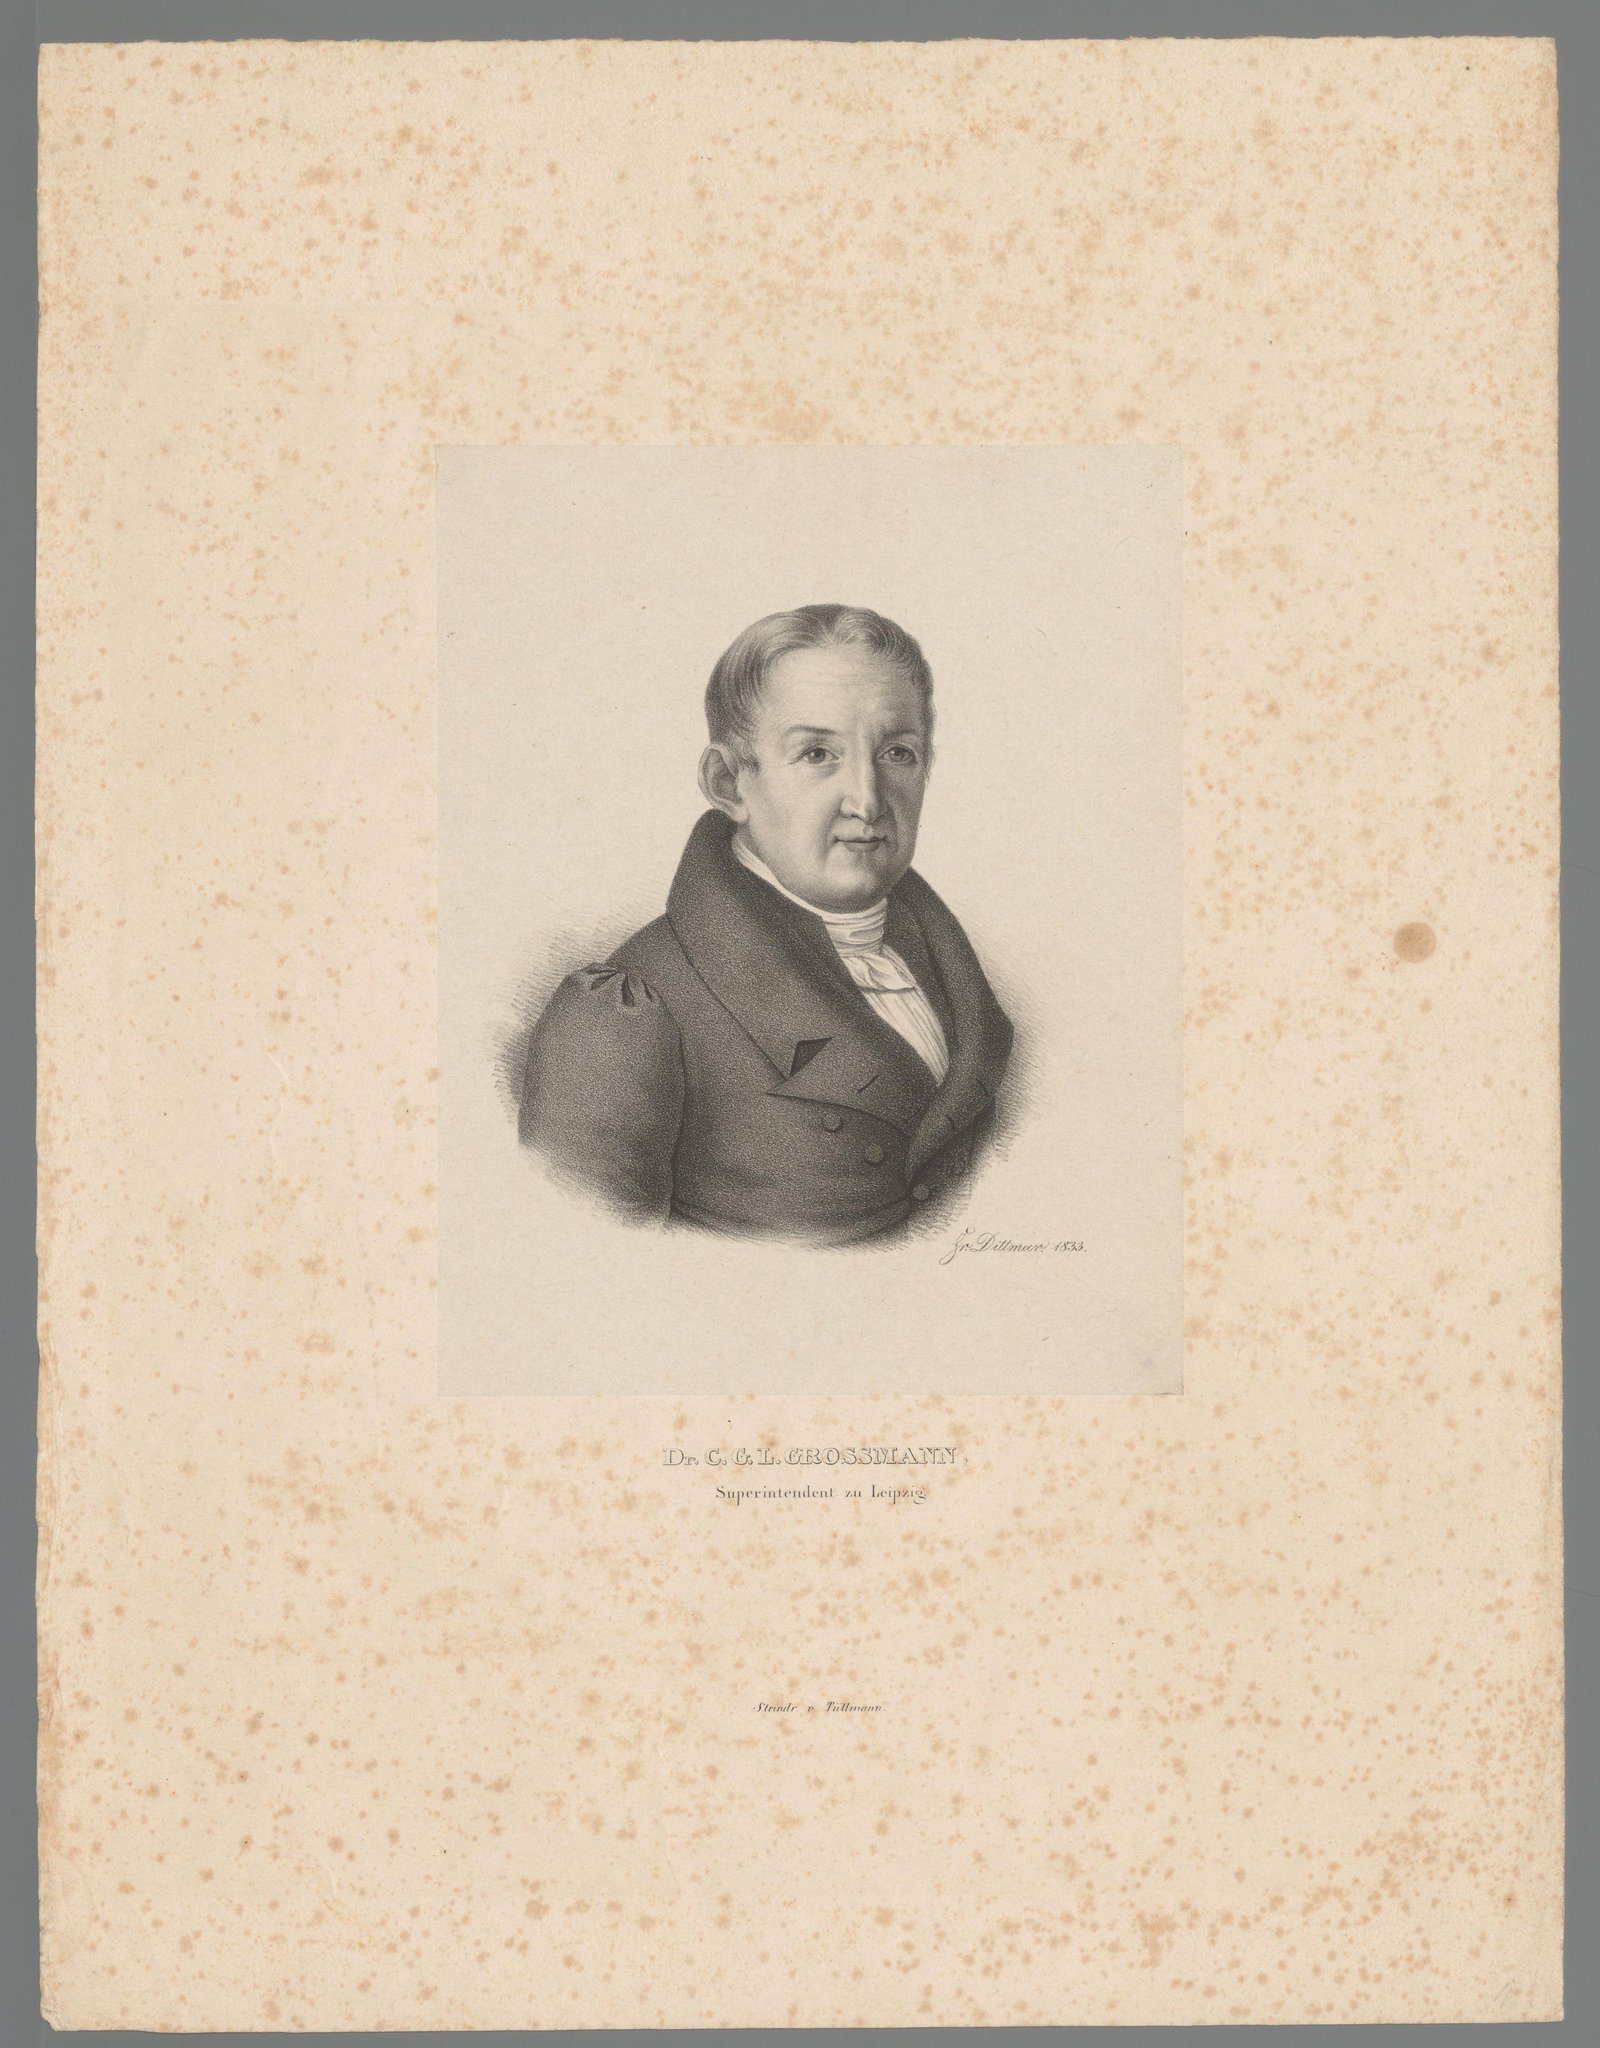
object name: print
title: Portret van Christian Gottlob Grossmann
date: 1833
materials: paper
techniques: lithograph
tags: adult man, historical persons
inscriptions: collector's mark: Lugt 2228